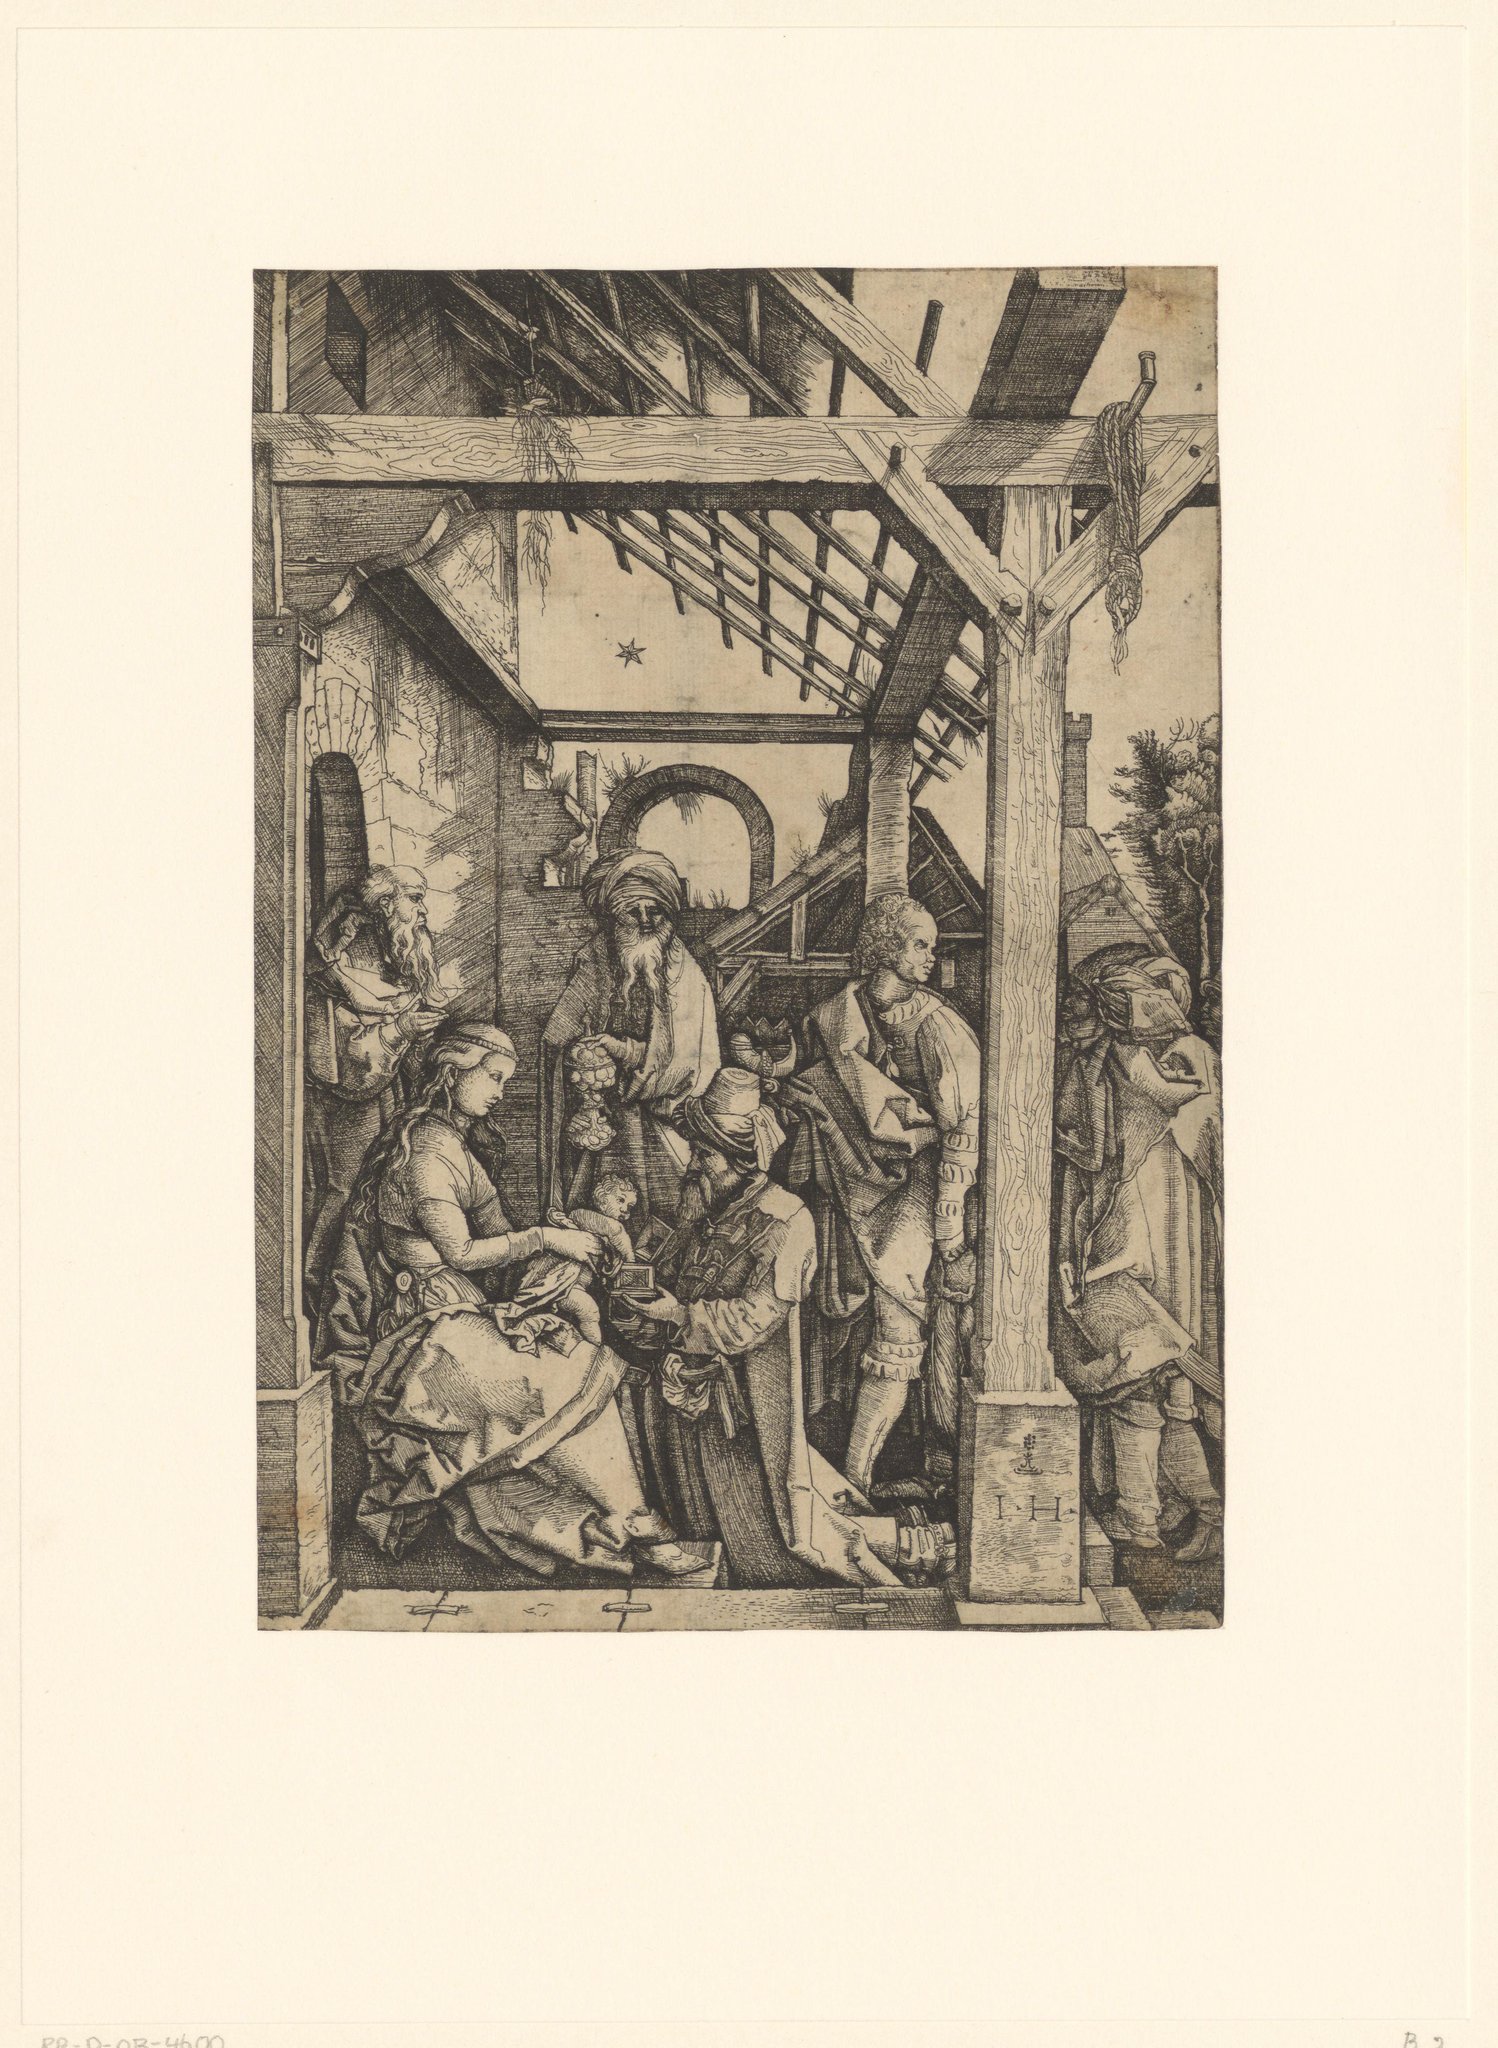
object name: print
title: Aanbidding der koningen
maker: hieronymus hopfer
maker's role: print maker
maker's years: 1500-1550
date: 1525-1550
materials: paper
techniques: etching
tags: adoration of the kings: the wise men present their gifts to the christ-child (gold, frankincense and myrrh)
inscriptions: collector's mark: Lugt 2228